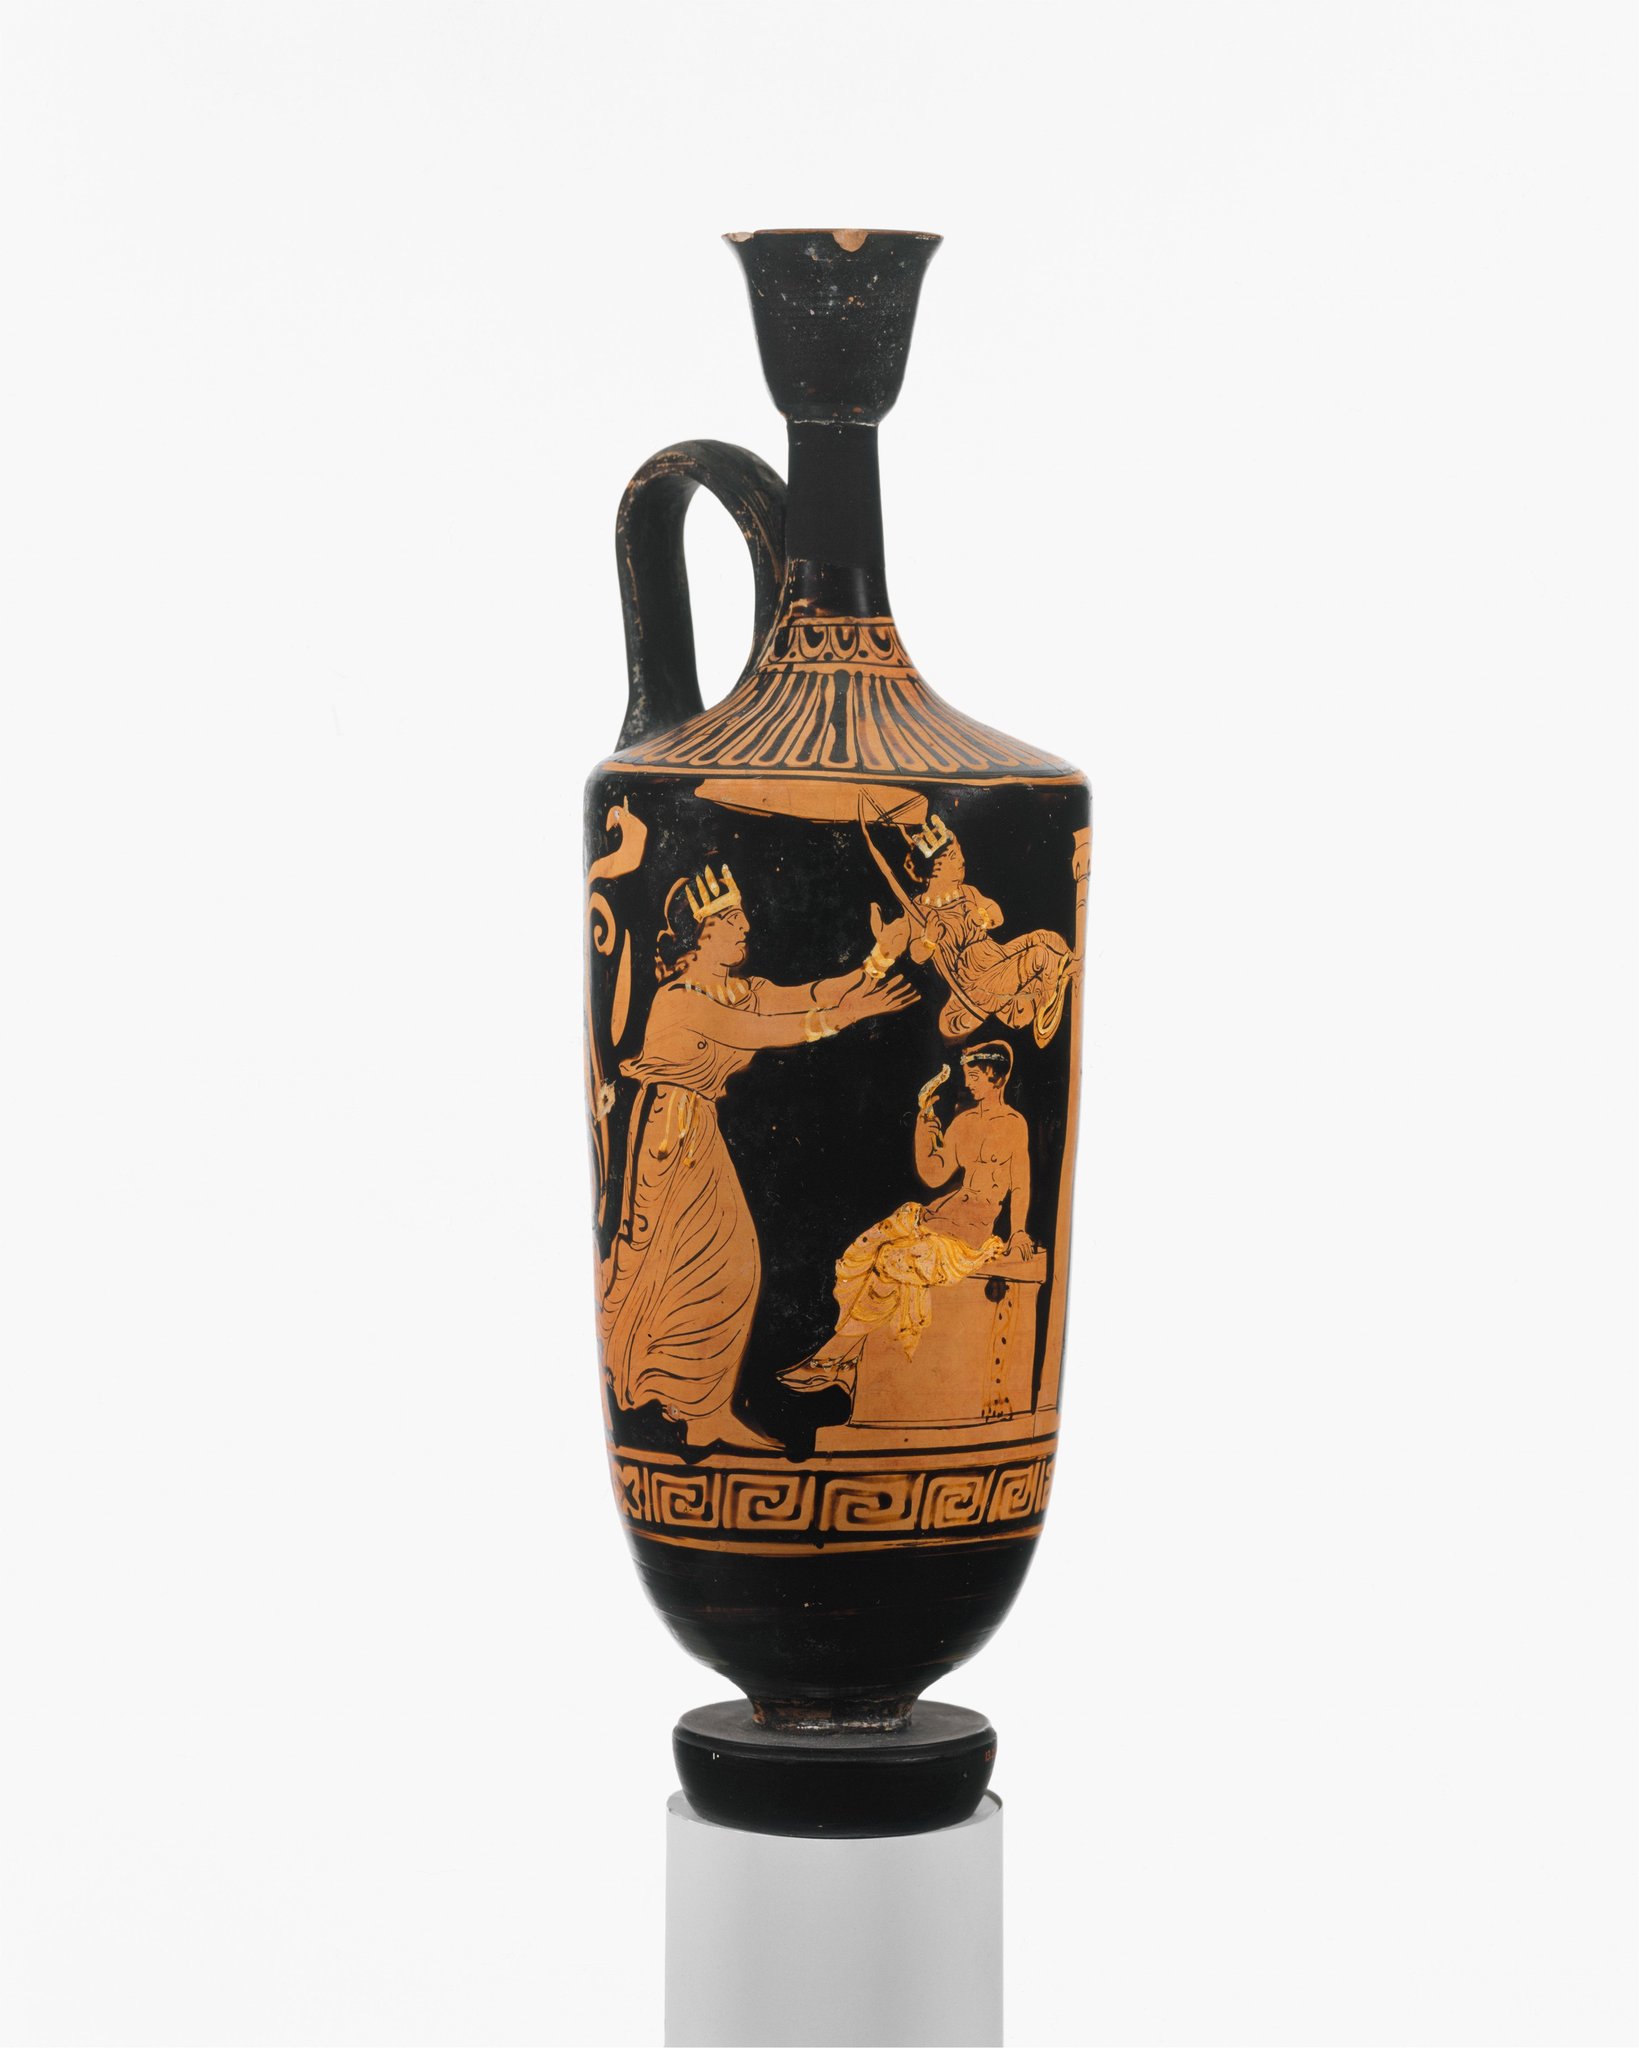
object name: lekythos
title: Terracotta lekythos (oil flask)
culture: greek, south italian, apulian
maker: lecce painter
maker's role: artist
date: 375-350 BCE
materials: terracotta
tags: boys,girls,women,hermes